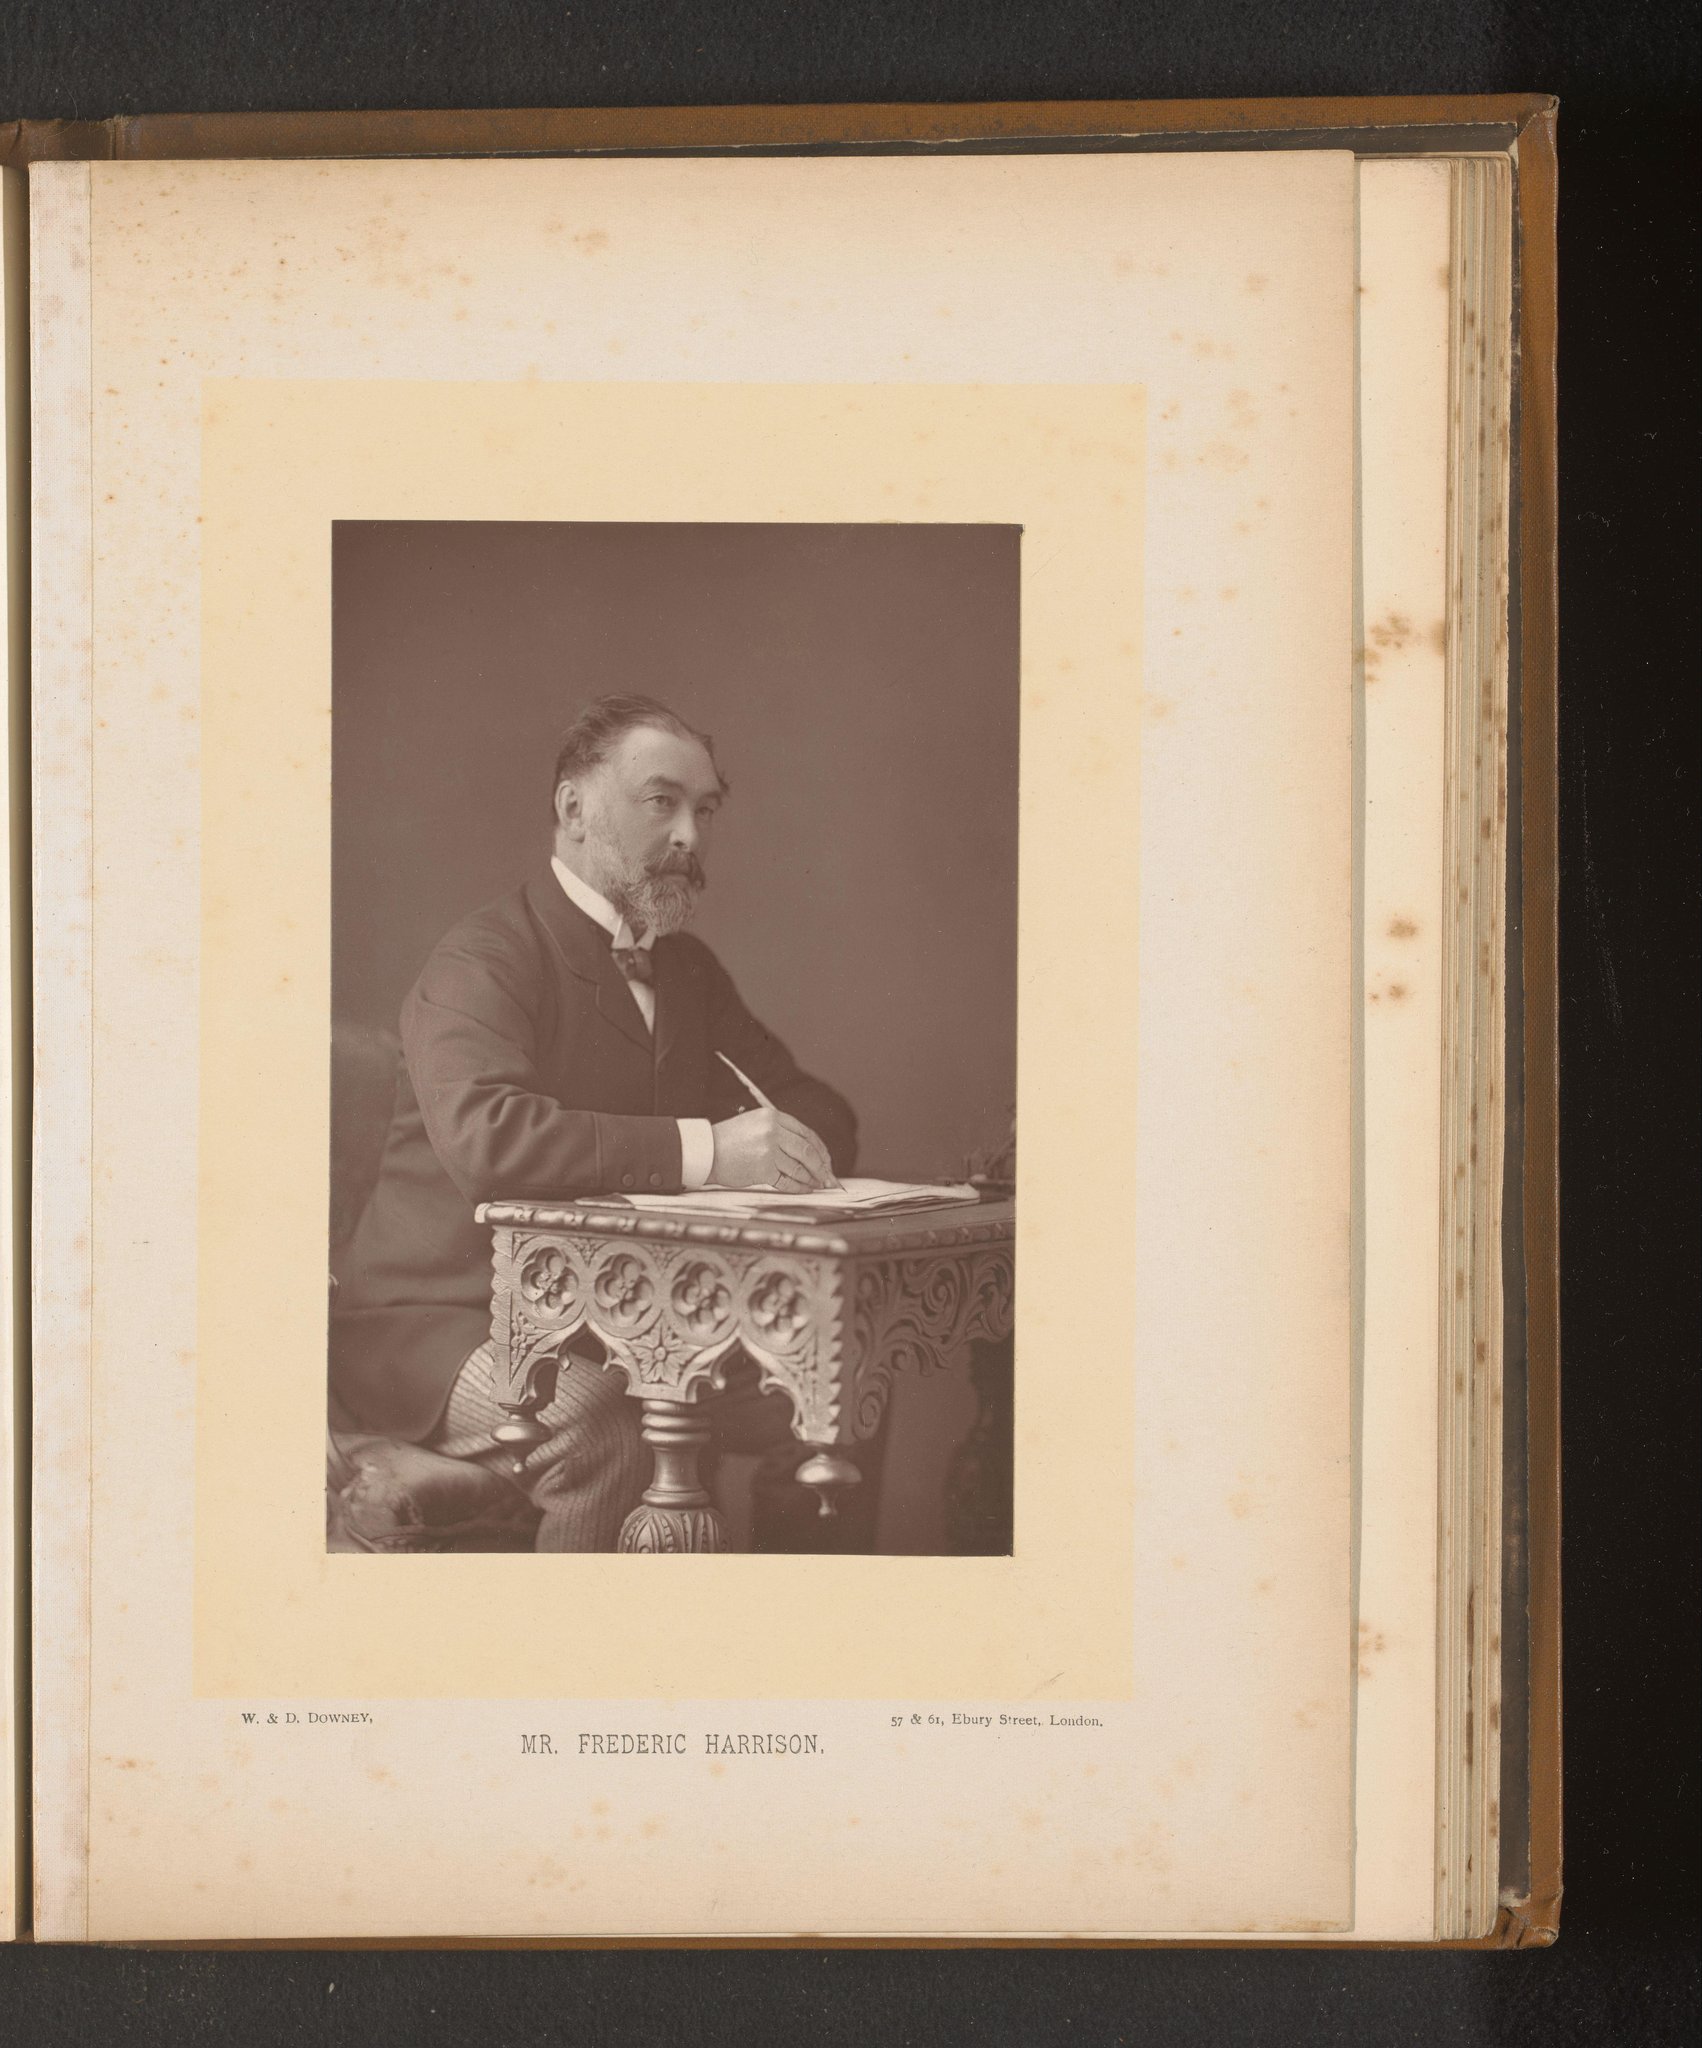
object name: photomechanical print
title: Mr. Frederic Harrison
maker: Anonymous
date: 1881-1891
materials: paper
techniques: woodburytype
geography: london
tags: writing-table, writing-desk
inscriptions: inscription: ‘57 & 61, Elbury Street, London.’